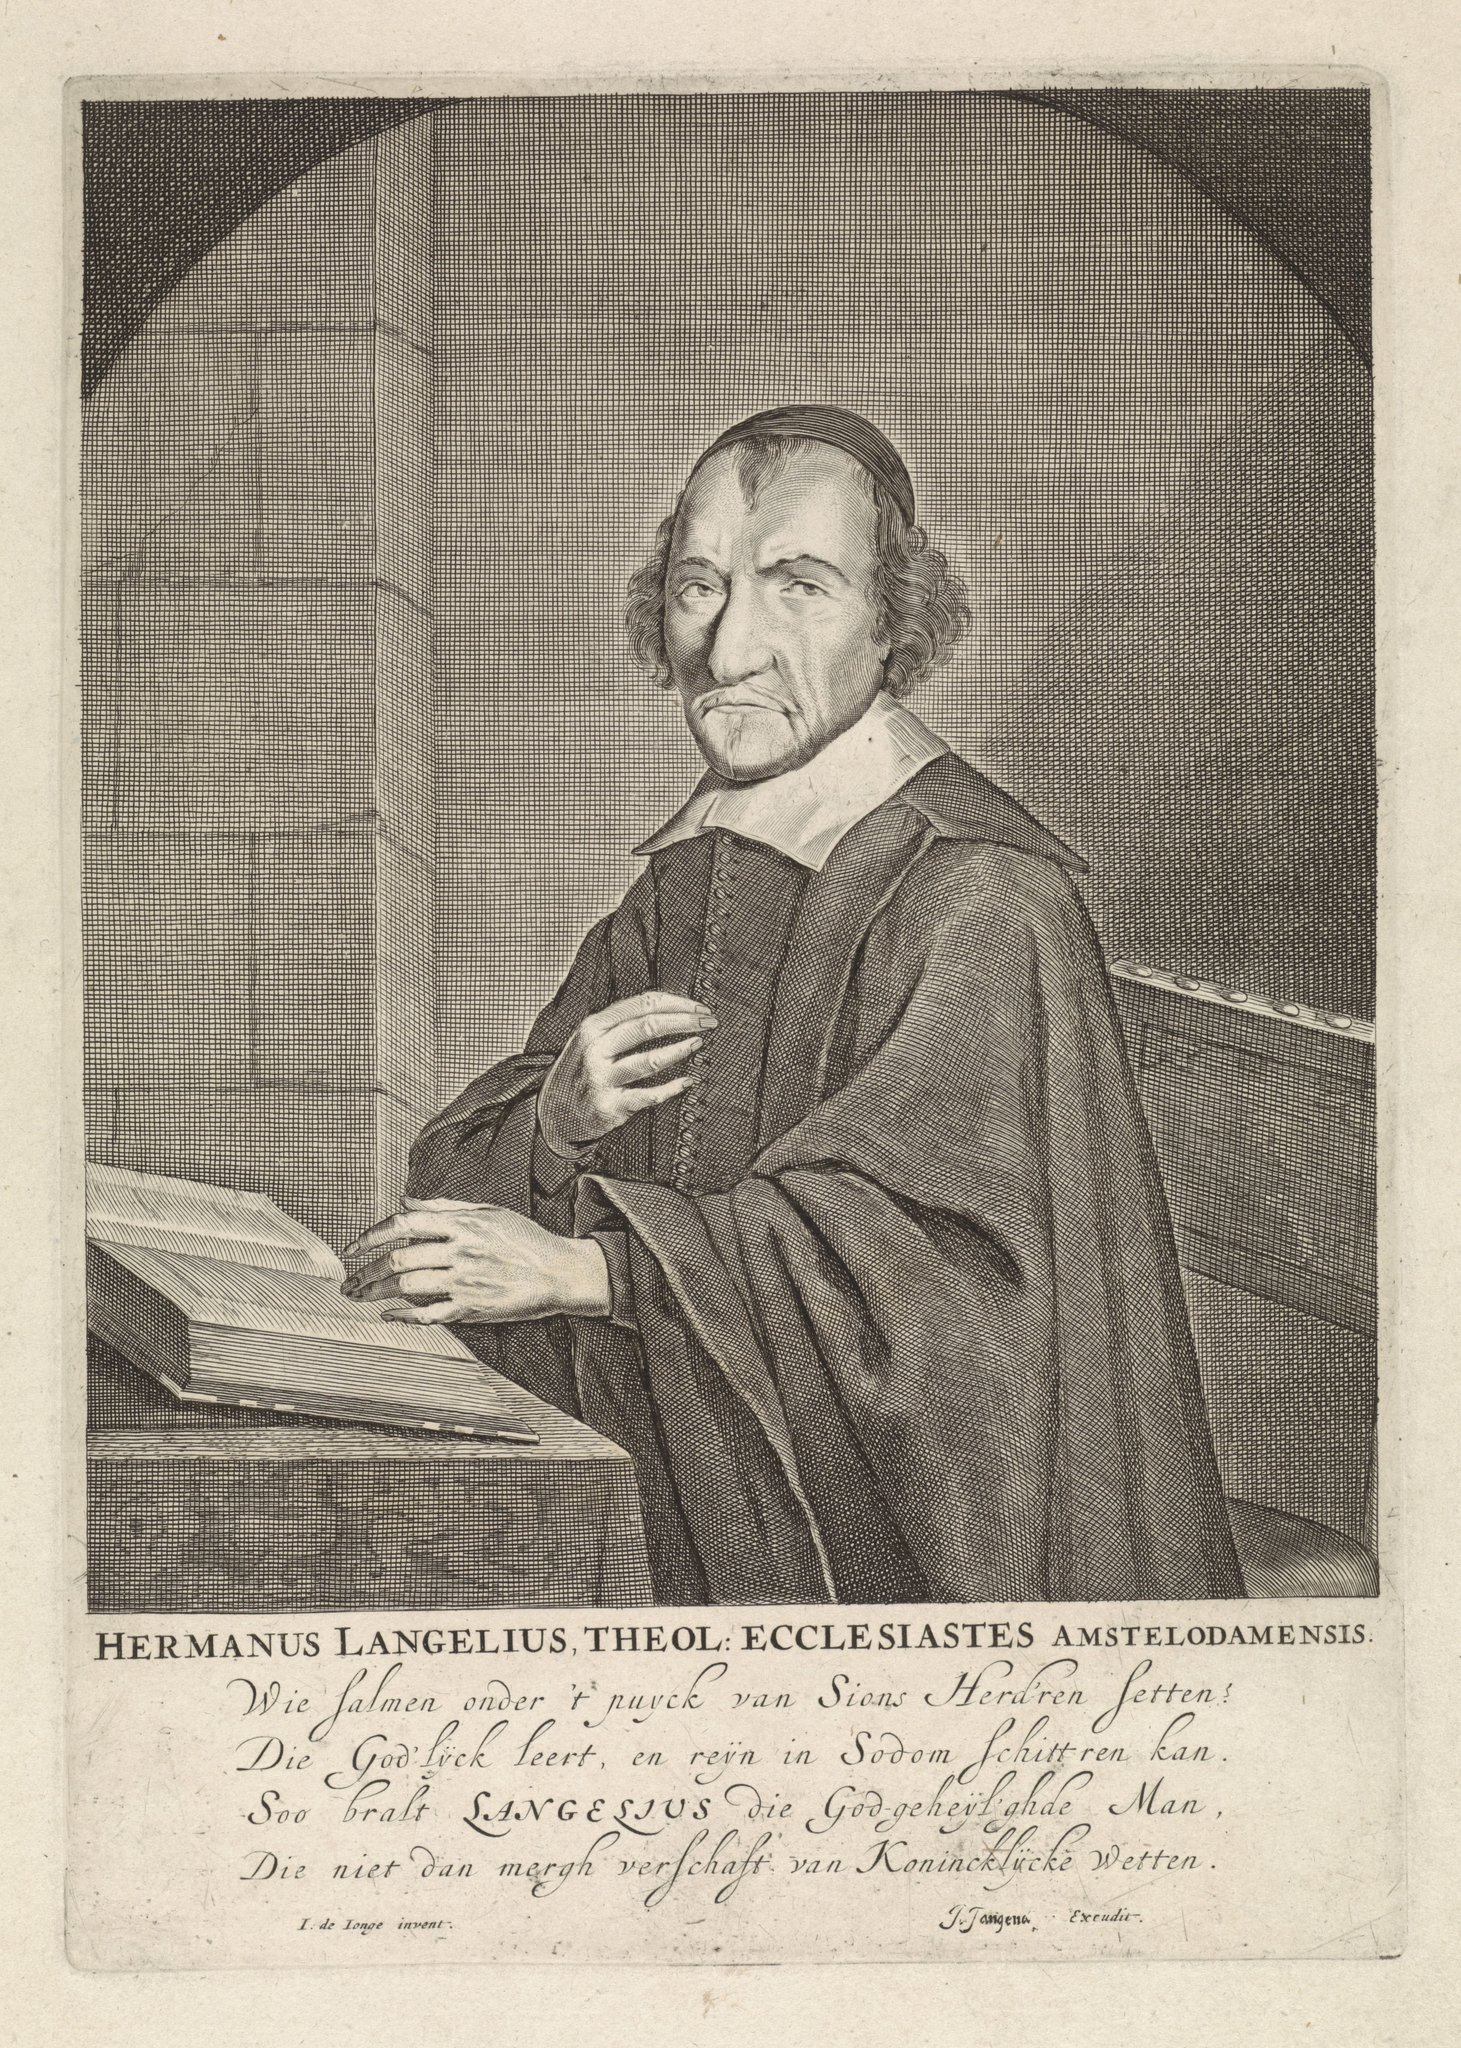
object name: print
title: Portret van de Amsterdamse predikant Hermanus Langelius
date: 1687-1691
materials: paper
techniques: engraving, etching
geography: leiden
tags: predikant, hermanus langelius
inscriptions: collector's mark: Lugt 2760, collector's mark: Lugt 2166